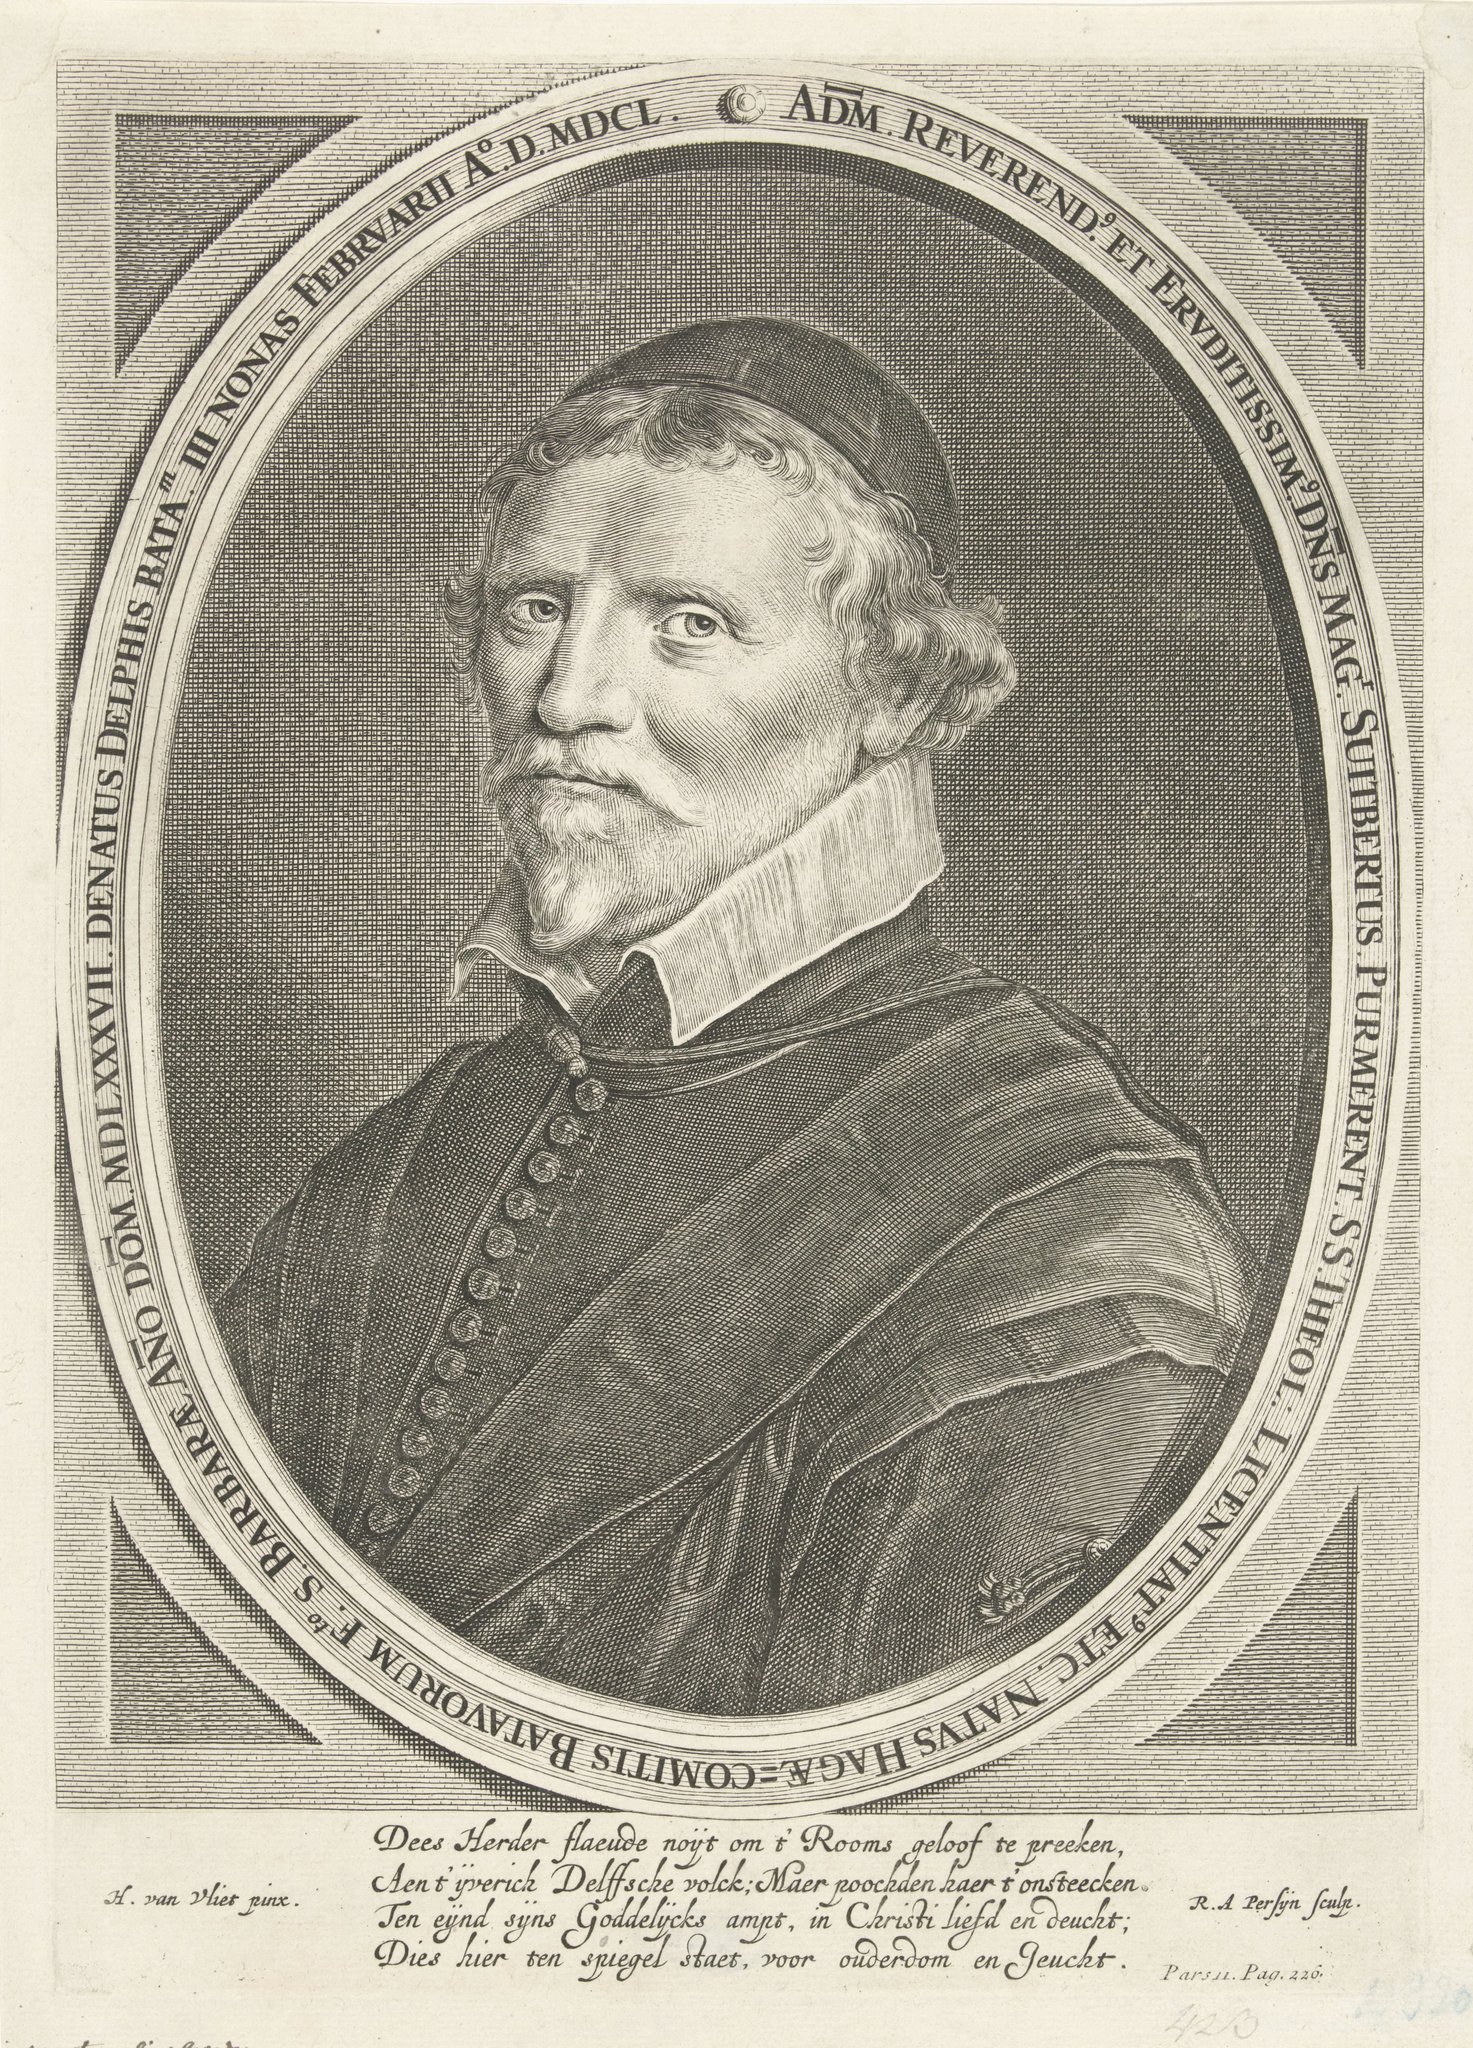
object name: print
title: Portret van Suitbertus Purmerent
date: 1650-1668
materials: paper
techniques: engraving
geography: gouda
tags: the hague, delft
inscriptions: inscription: ‘1587 tweelingbroer’, collector's mark: Lugt 2228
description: Prent gebruikt in: Heussen, Hugo Franciscus van, Historia episcopatuum Foederati Belgii; utpote metropolitani Ultrajectini, nec non suffraganeorum Harlemensis, Daventriensis, Leovardensis, Groningensis, et Middelburgensis. Leiden: Christiaan Vermey, 1719.